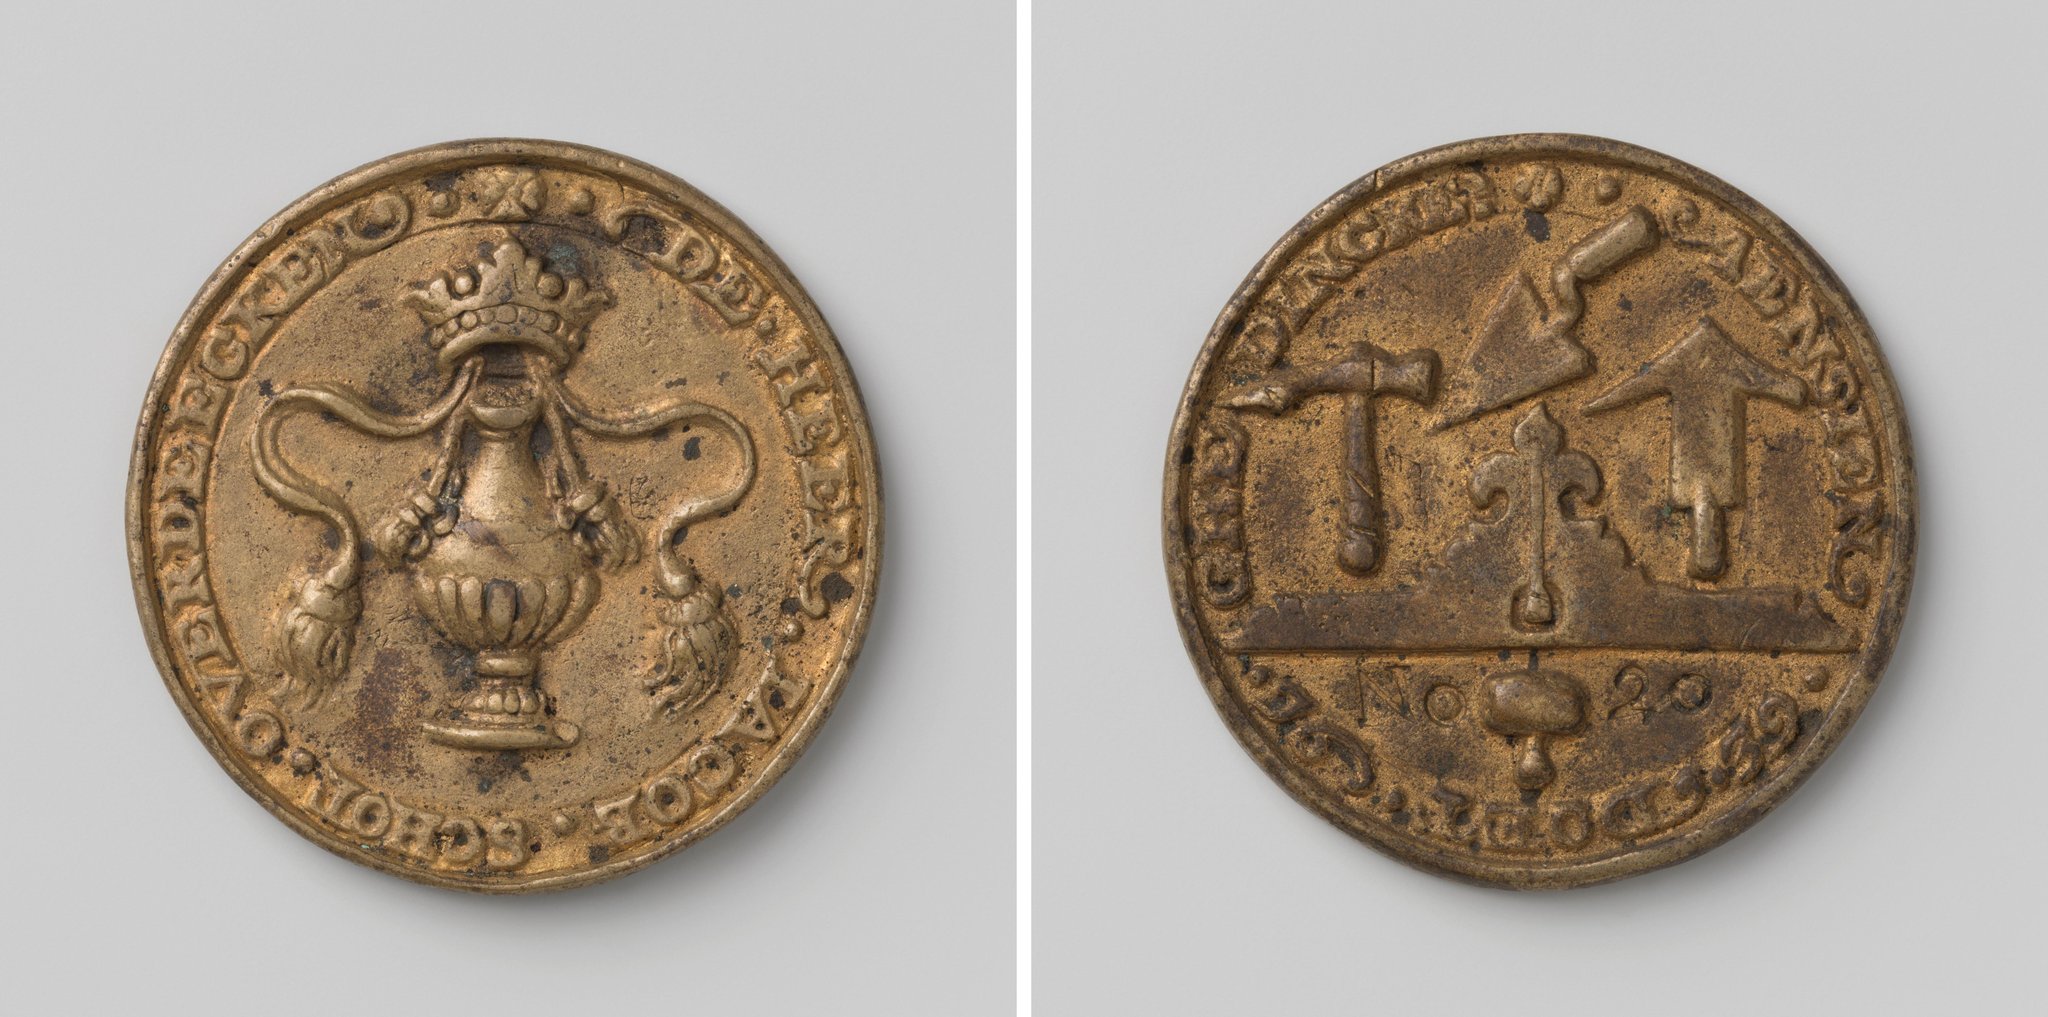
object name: medal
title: Metselaarsgilde van Vlissingen, gildepenning met no. 20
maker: johannes looff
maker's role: die cutter, draughtsman, print maker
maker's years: -1651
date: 1639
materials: brass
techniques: casting, engraving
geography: flushing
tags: flushing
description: Messing penning. Voorzijde: gekroonde fles; aan kroon: linten binnen omschrift. Keerzijde: hamer, troffel en loodgietershamer boven waterpas en opschrift No. 20, onderbroken door metselaarshamer